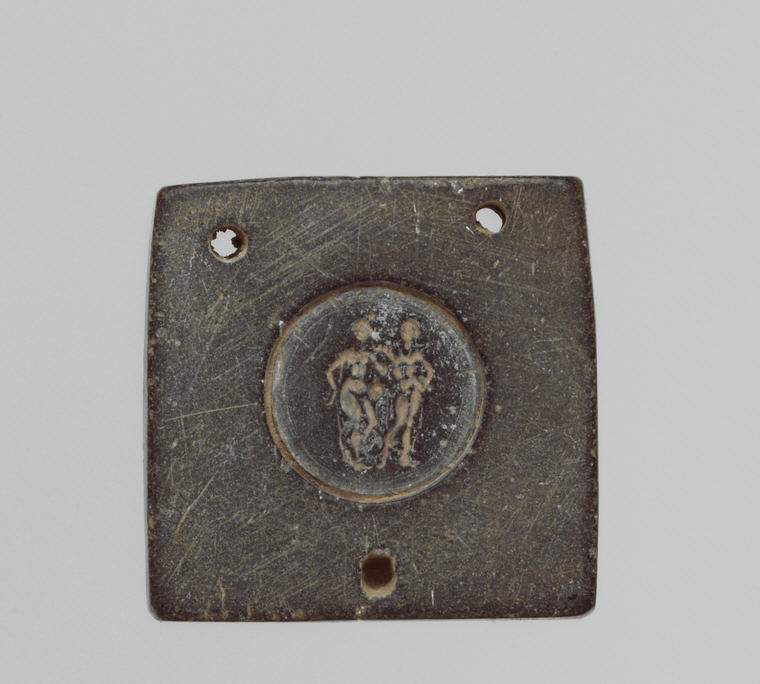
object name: jewelry mold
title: Jewelry Mold With Two Figures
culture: gandhara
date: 1-100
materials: stone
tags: gandhara,female nudes